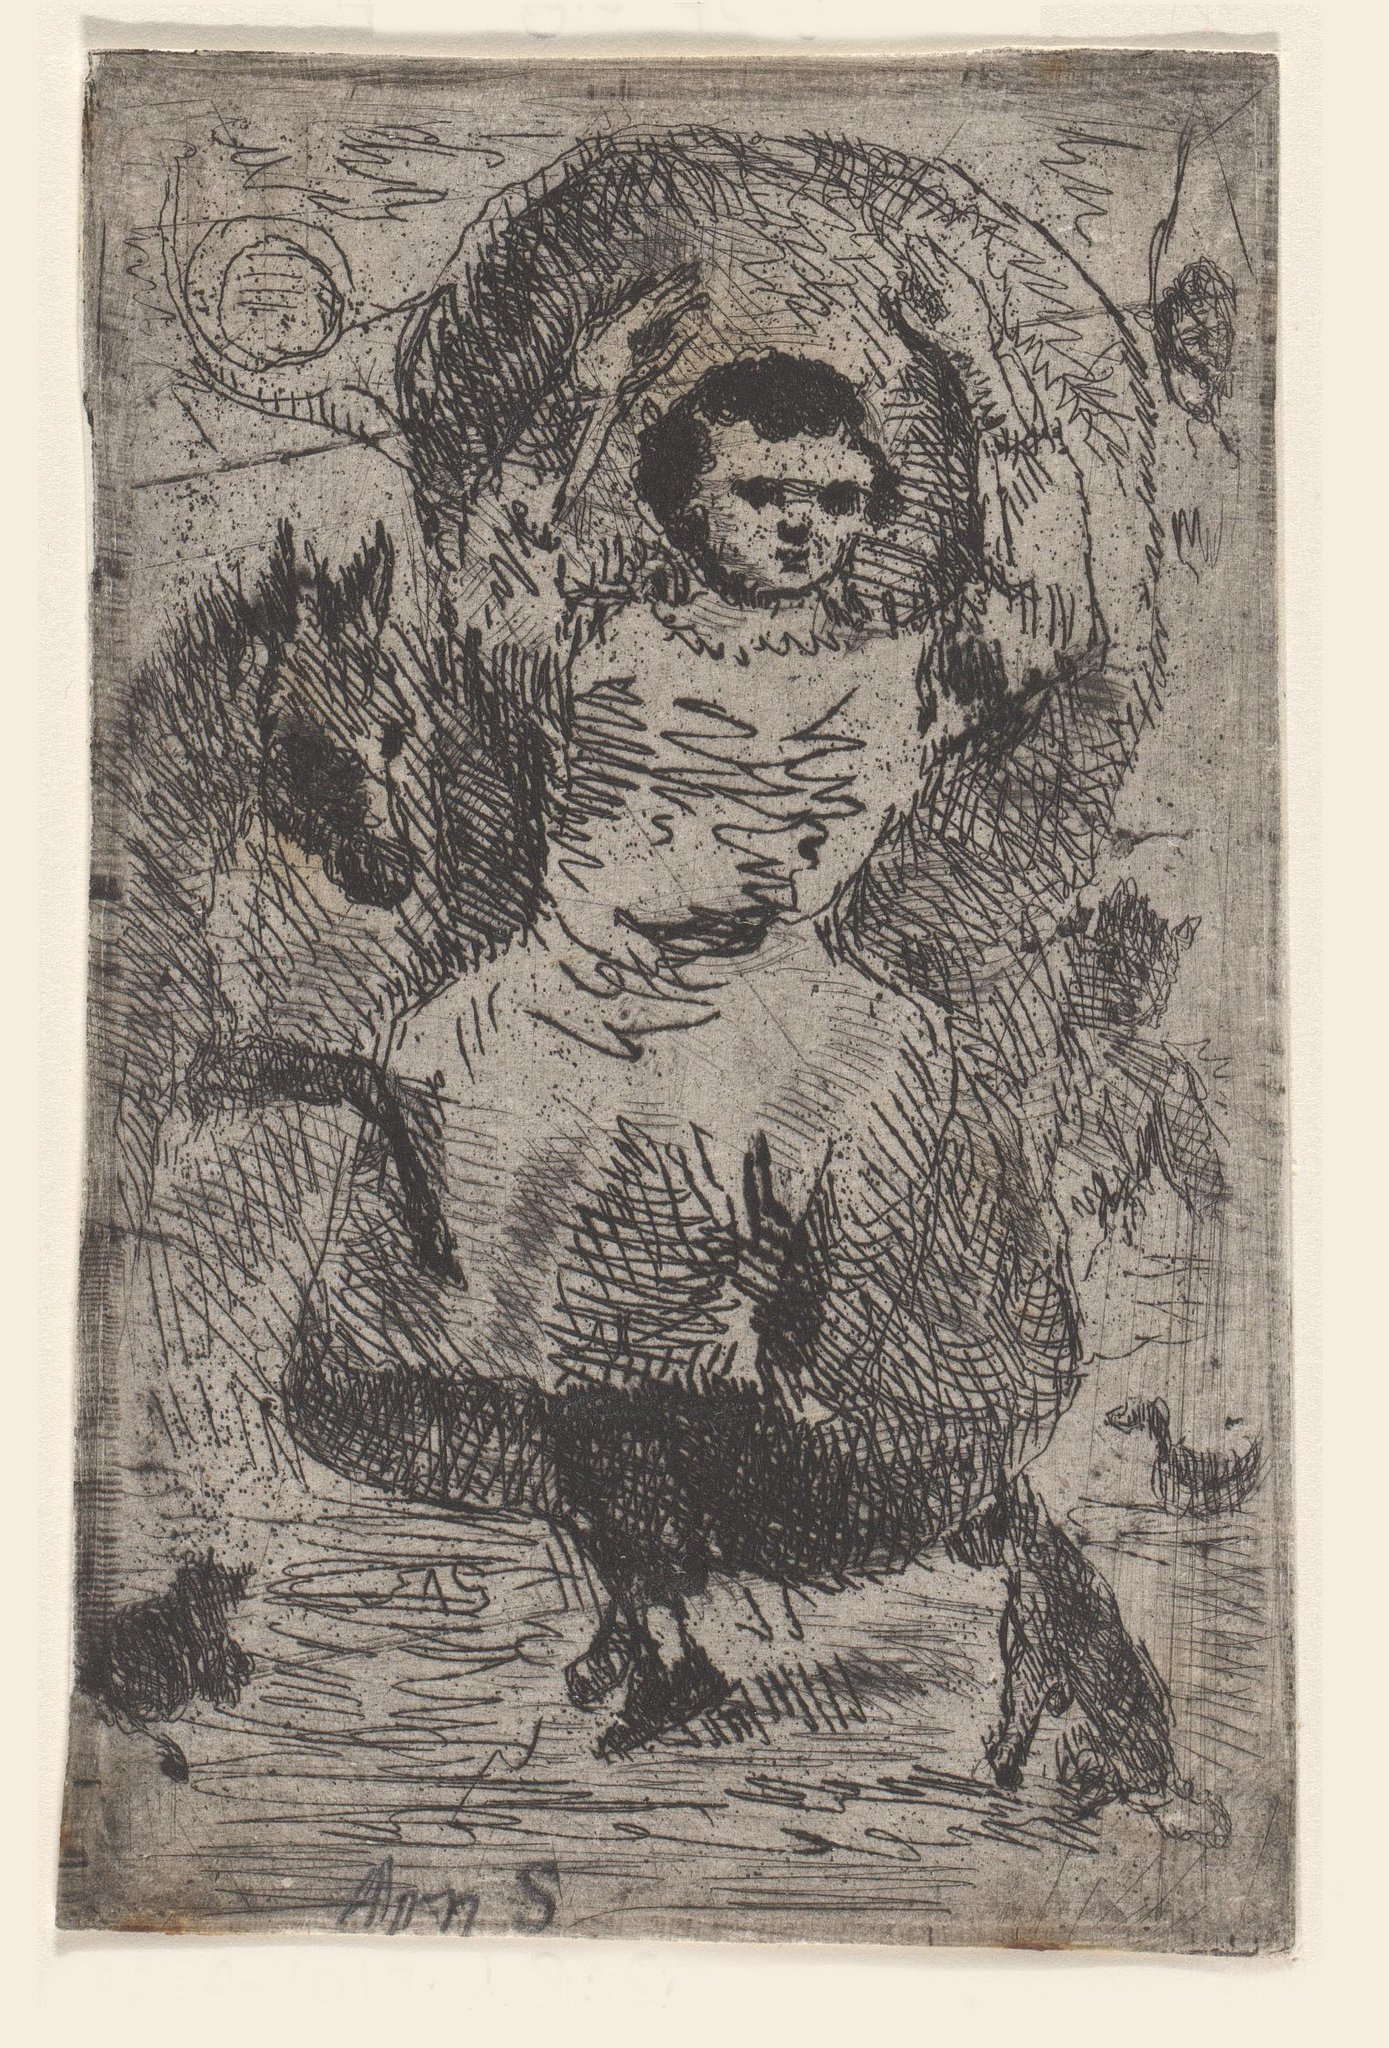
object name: print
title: Jong meisje omringd door dieren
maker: arnoud schaepkens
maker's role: print maker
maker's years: 1816-1904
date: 1831-1904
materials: paper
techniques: drypoint, etching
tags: animals, girl (child between toddler and youth)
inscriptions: collector's mark: Lugt 2228